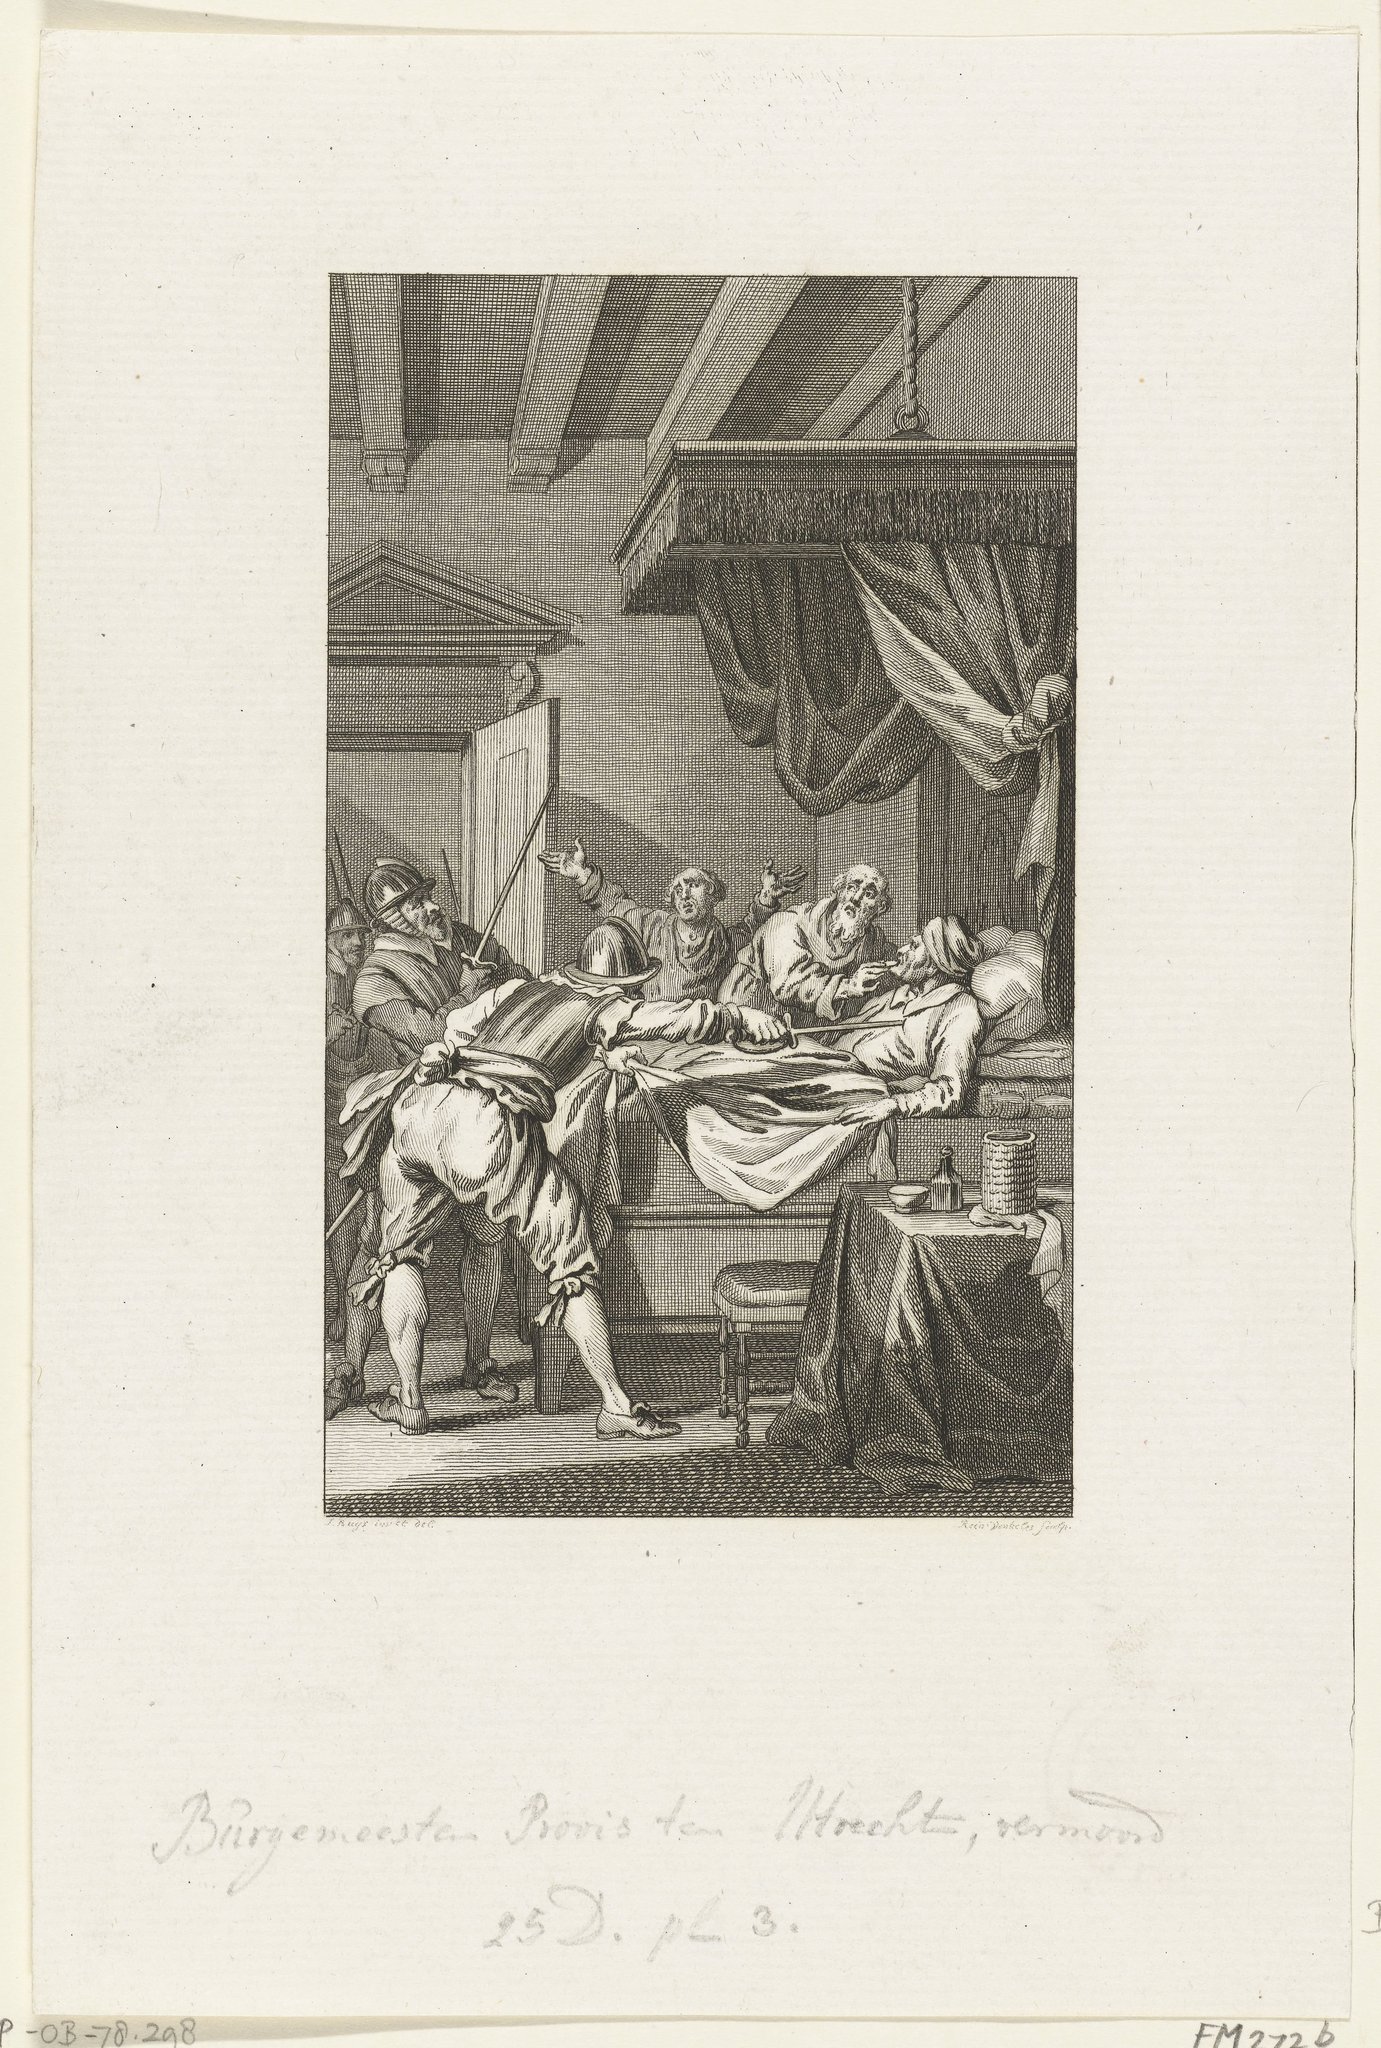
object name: history print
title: Burgemeester Beernt Proys te Utrecht, vermoord, 1425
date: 1791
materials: paper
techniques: etching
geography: netherlands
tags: utrecht, violent death, being killed; being mishandled and maltreated; seeking death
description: Illustratie voor: Jacobus Kok, Vaderlandsch Woordenboek, Johannes Allart, Amsterdam 1785-1799, 35 delen, dl. XXV, pl. III. Staat vóór de letter.